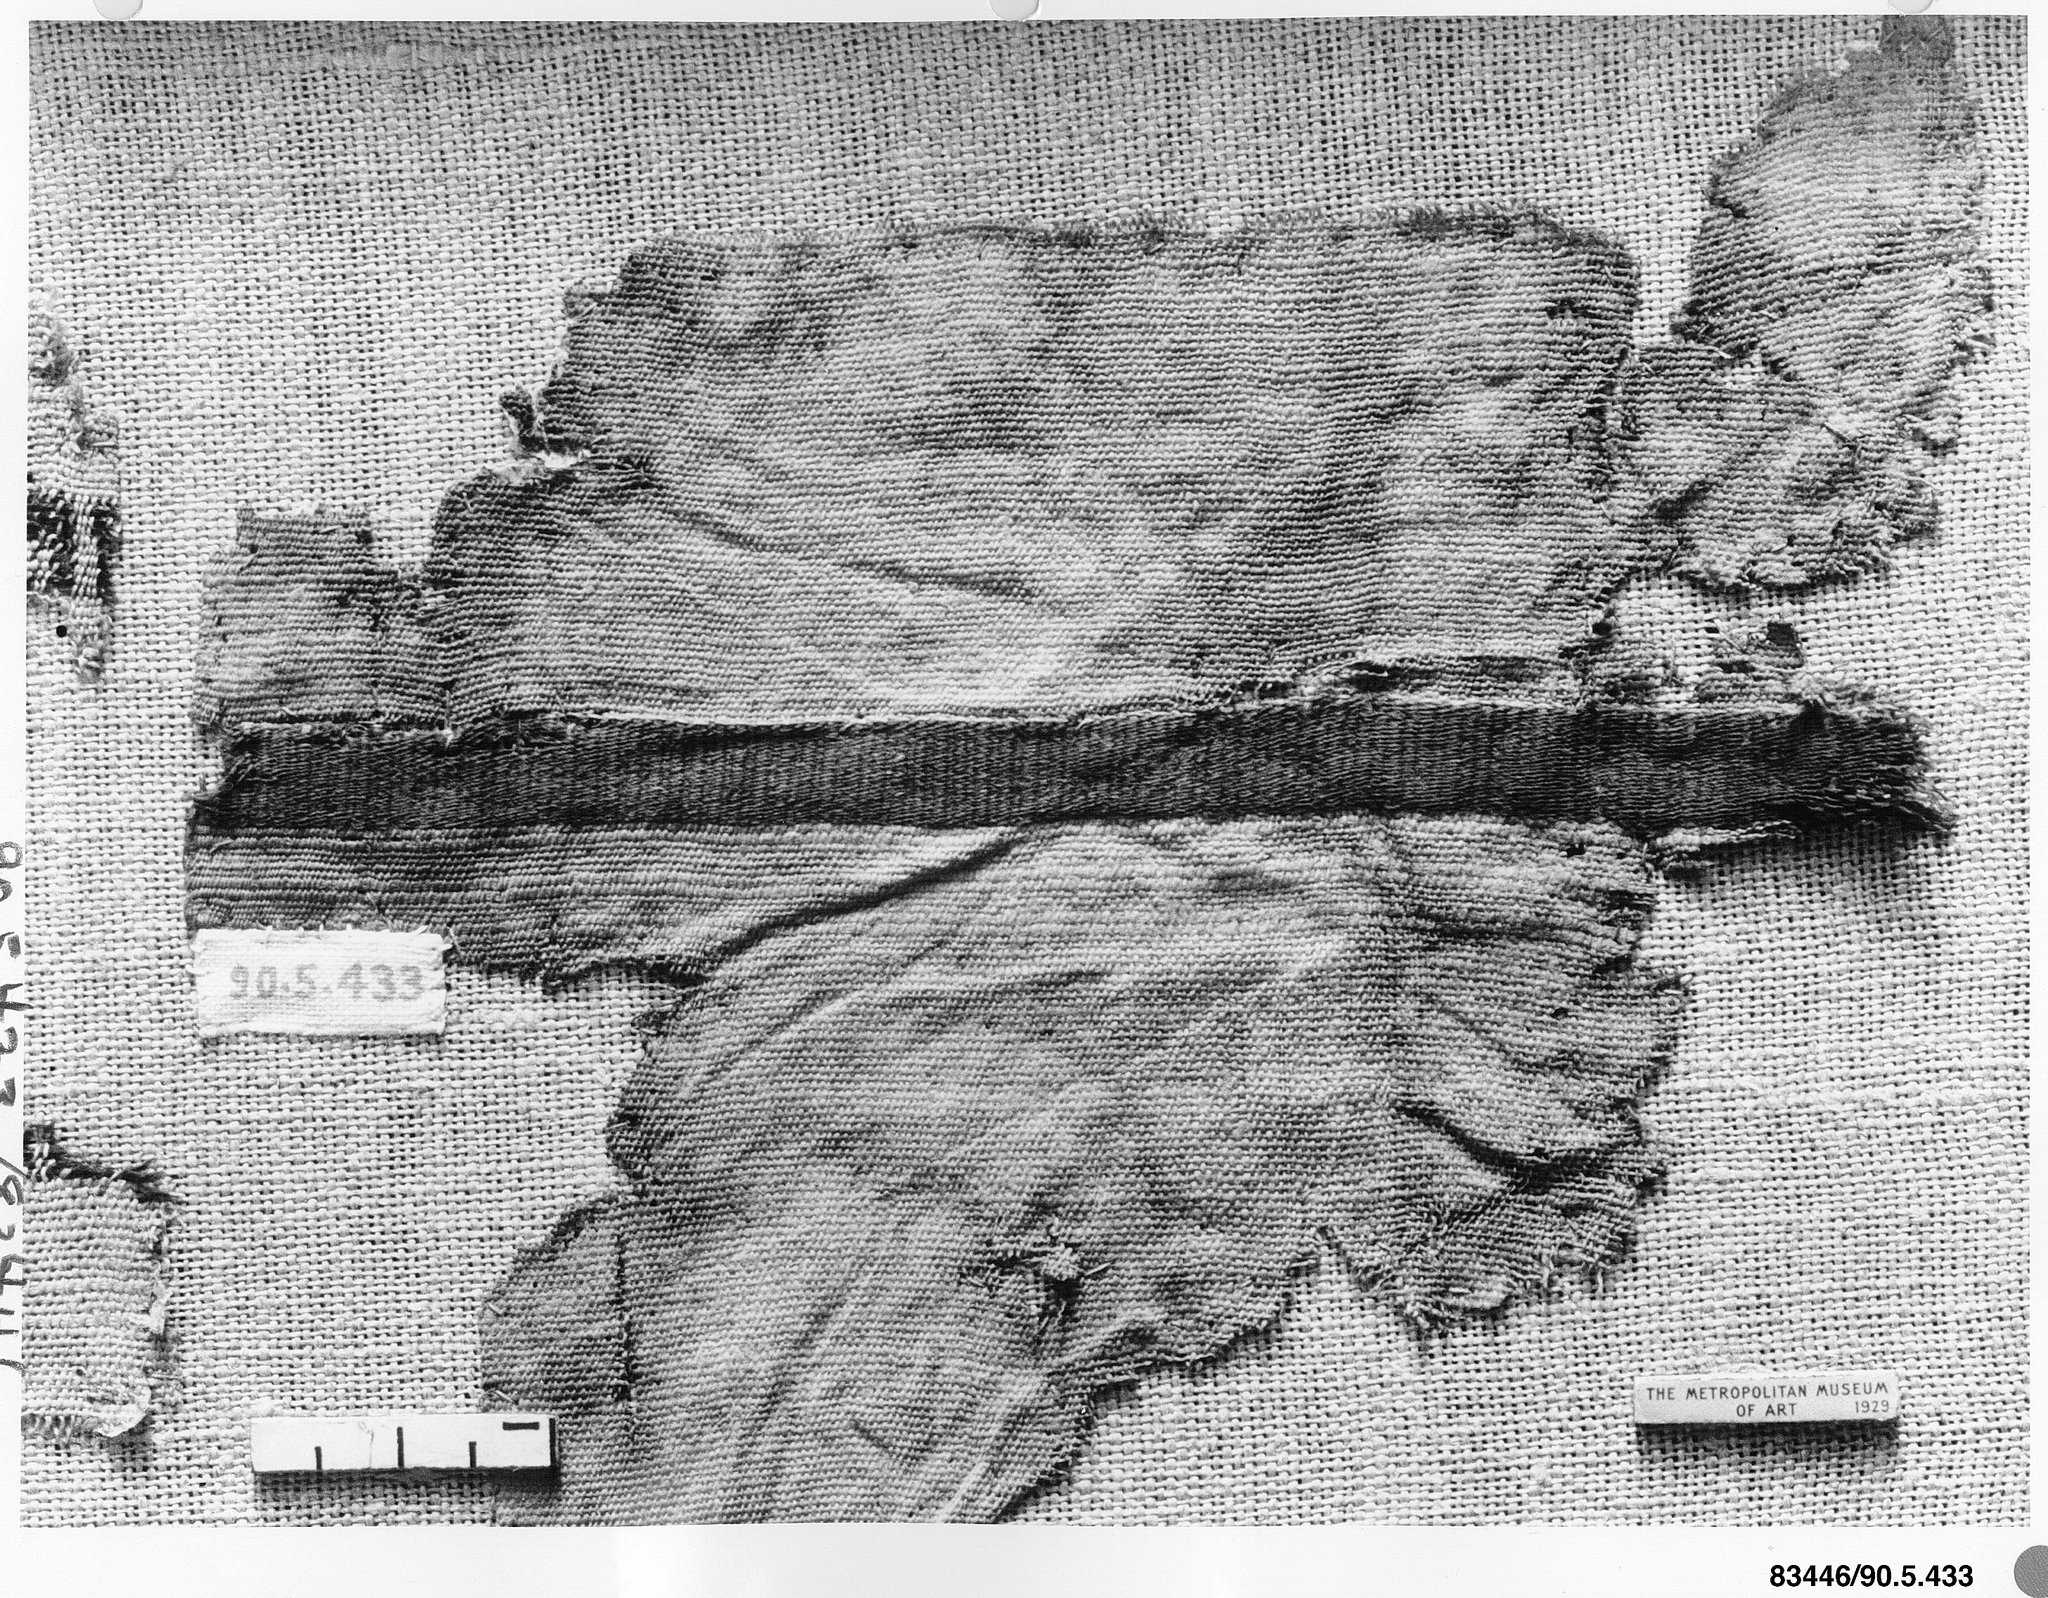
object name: textile fragment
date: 101-300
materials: linen, wool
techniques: weave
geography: egypt